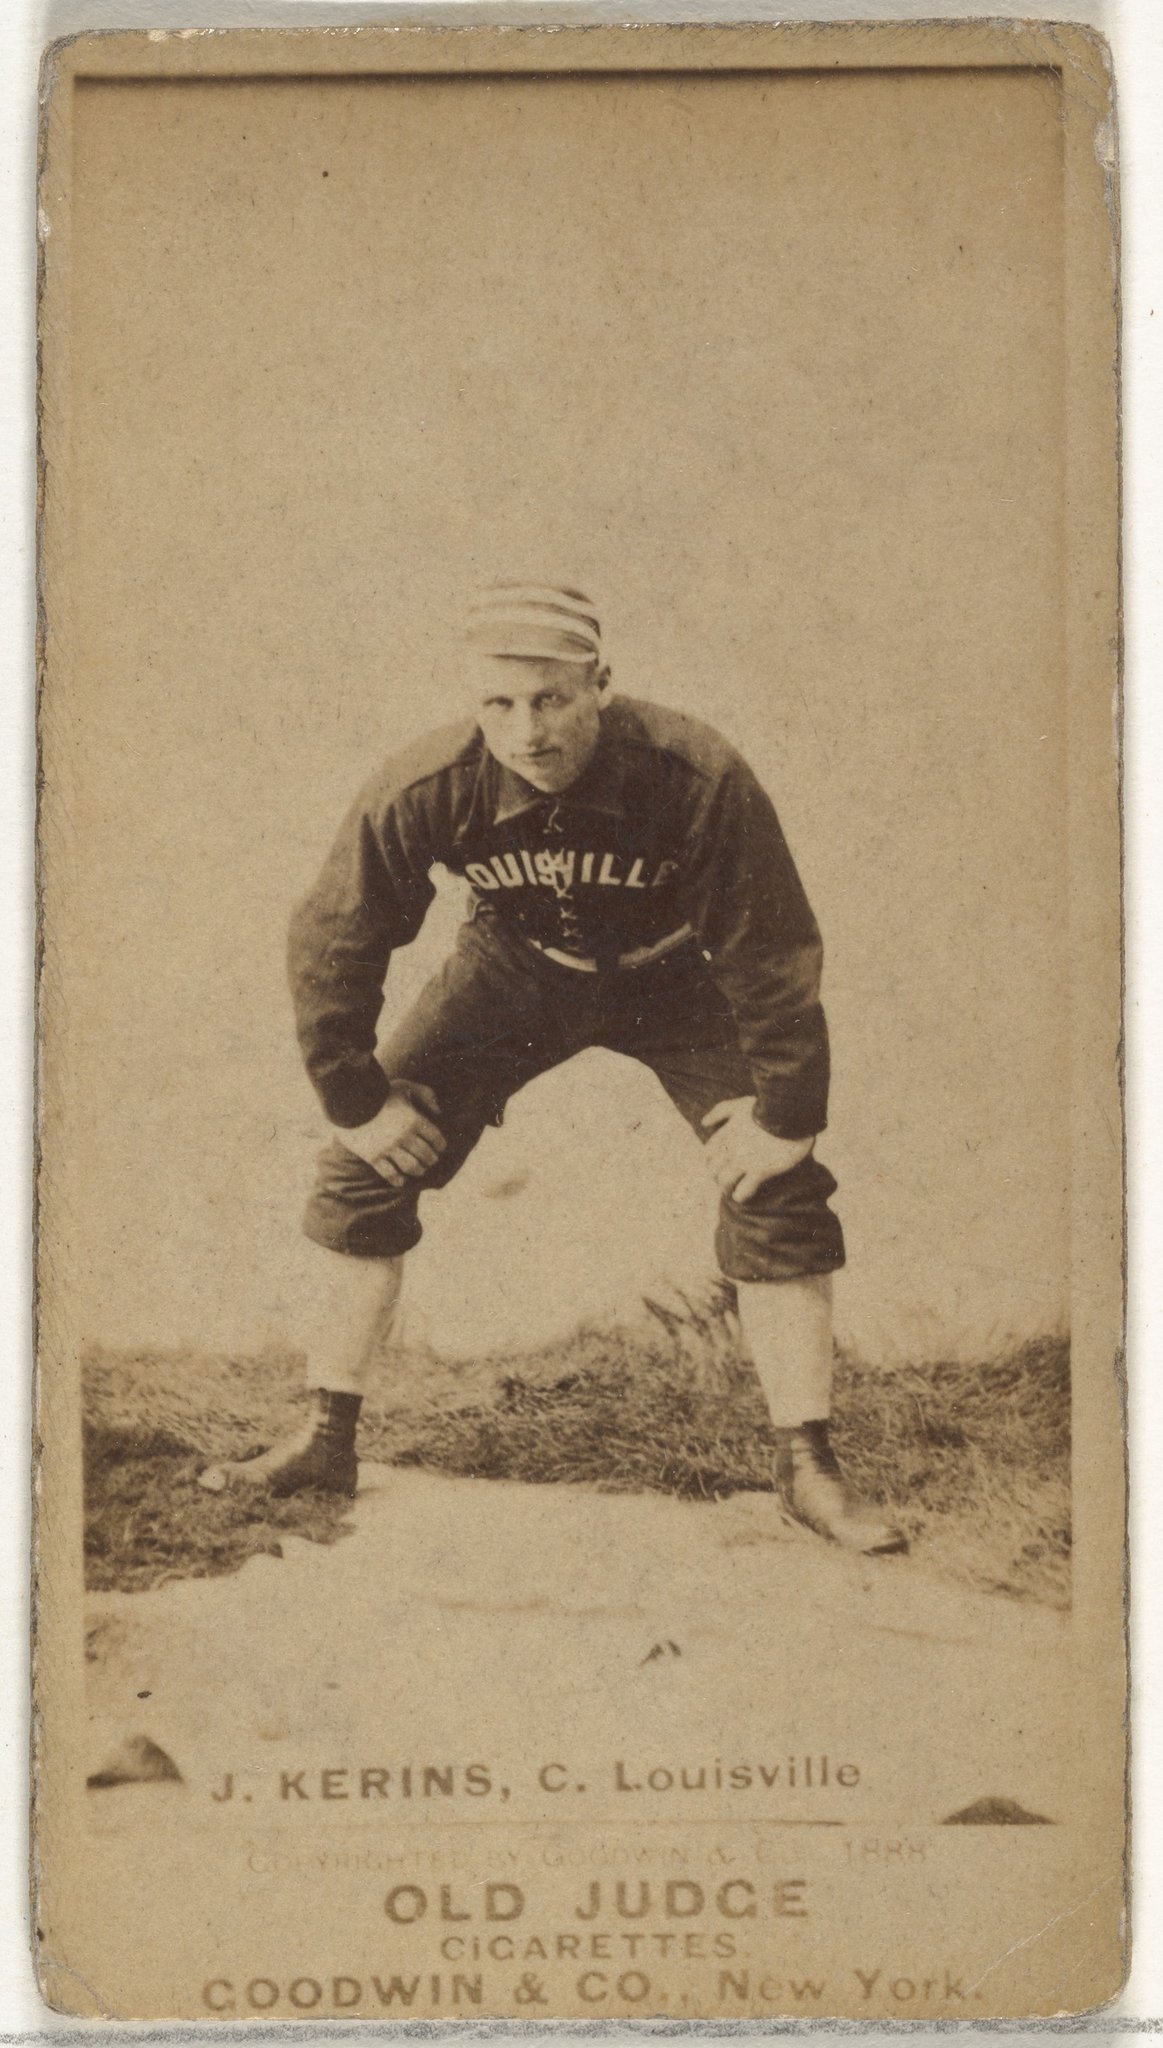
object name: baseball card, photograph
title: John Nelson Kerins, Catcher, Louisville Colonels, from the Old Judge series (N172) for Old Judge Cigarettes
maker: goodwin & company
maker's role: publisher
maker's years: 1850-1950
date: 1888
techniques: albumen silver print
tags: men,portraits,baseball,athletes